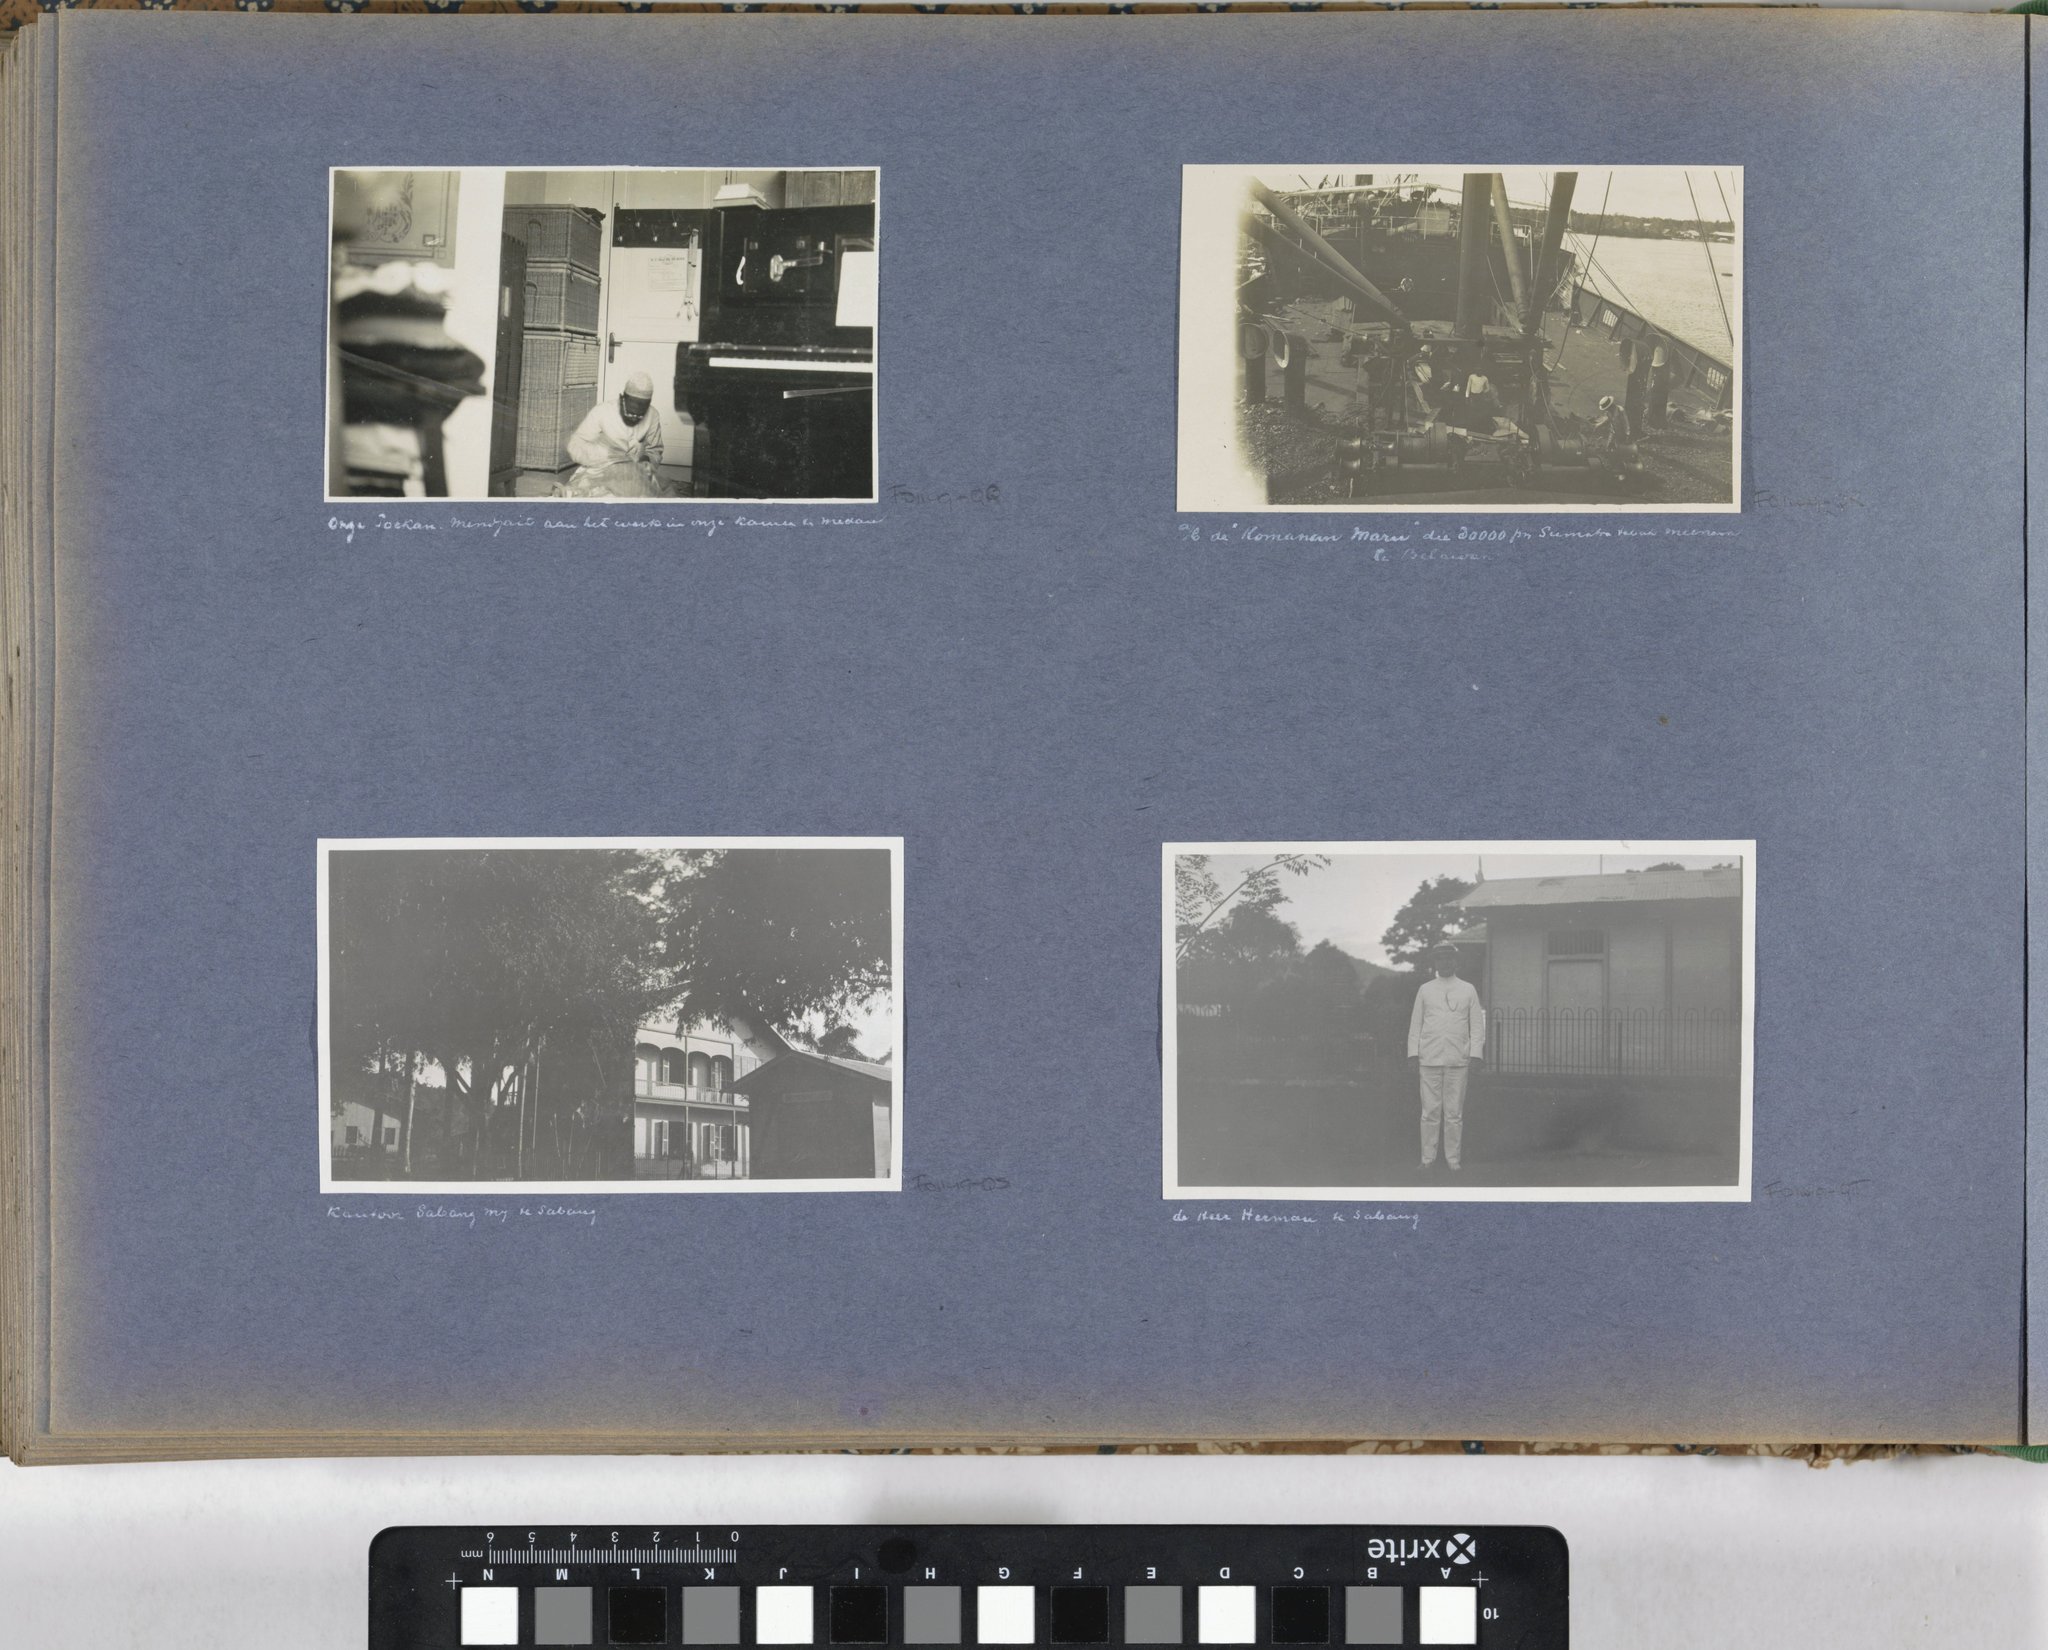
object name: photograph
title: Gezicht op het dek van een schip (Komanam Maru) voor tabaksvervoer te Belawan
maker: Anonymous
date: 1900-1920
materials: paper, photographic support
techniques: gelatin silver print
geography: belawan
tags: freight vessel, parts of ship's exterior: deck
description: Onderdeel van reisalbum met foto's van bedrijvigheid en bezienswaardigheden op Sumatra en Java en van de reis naar en van Nederlands-Indië.